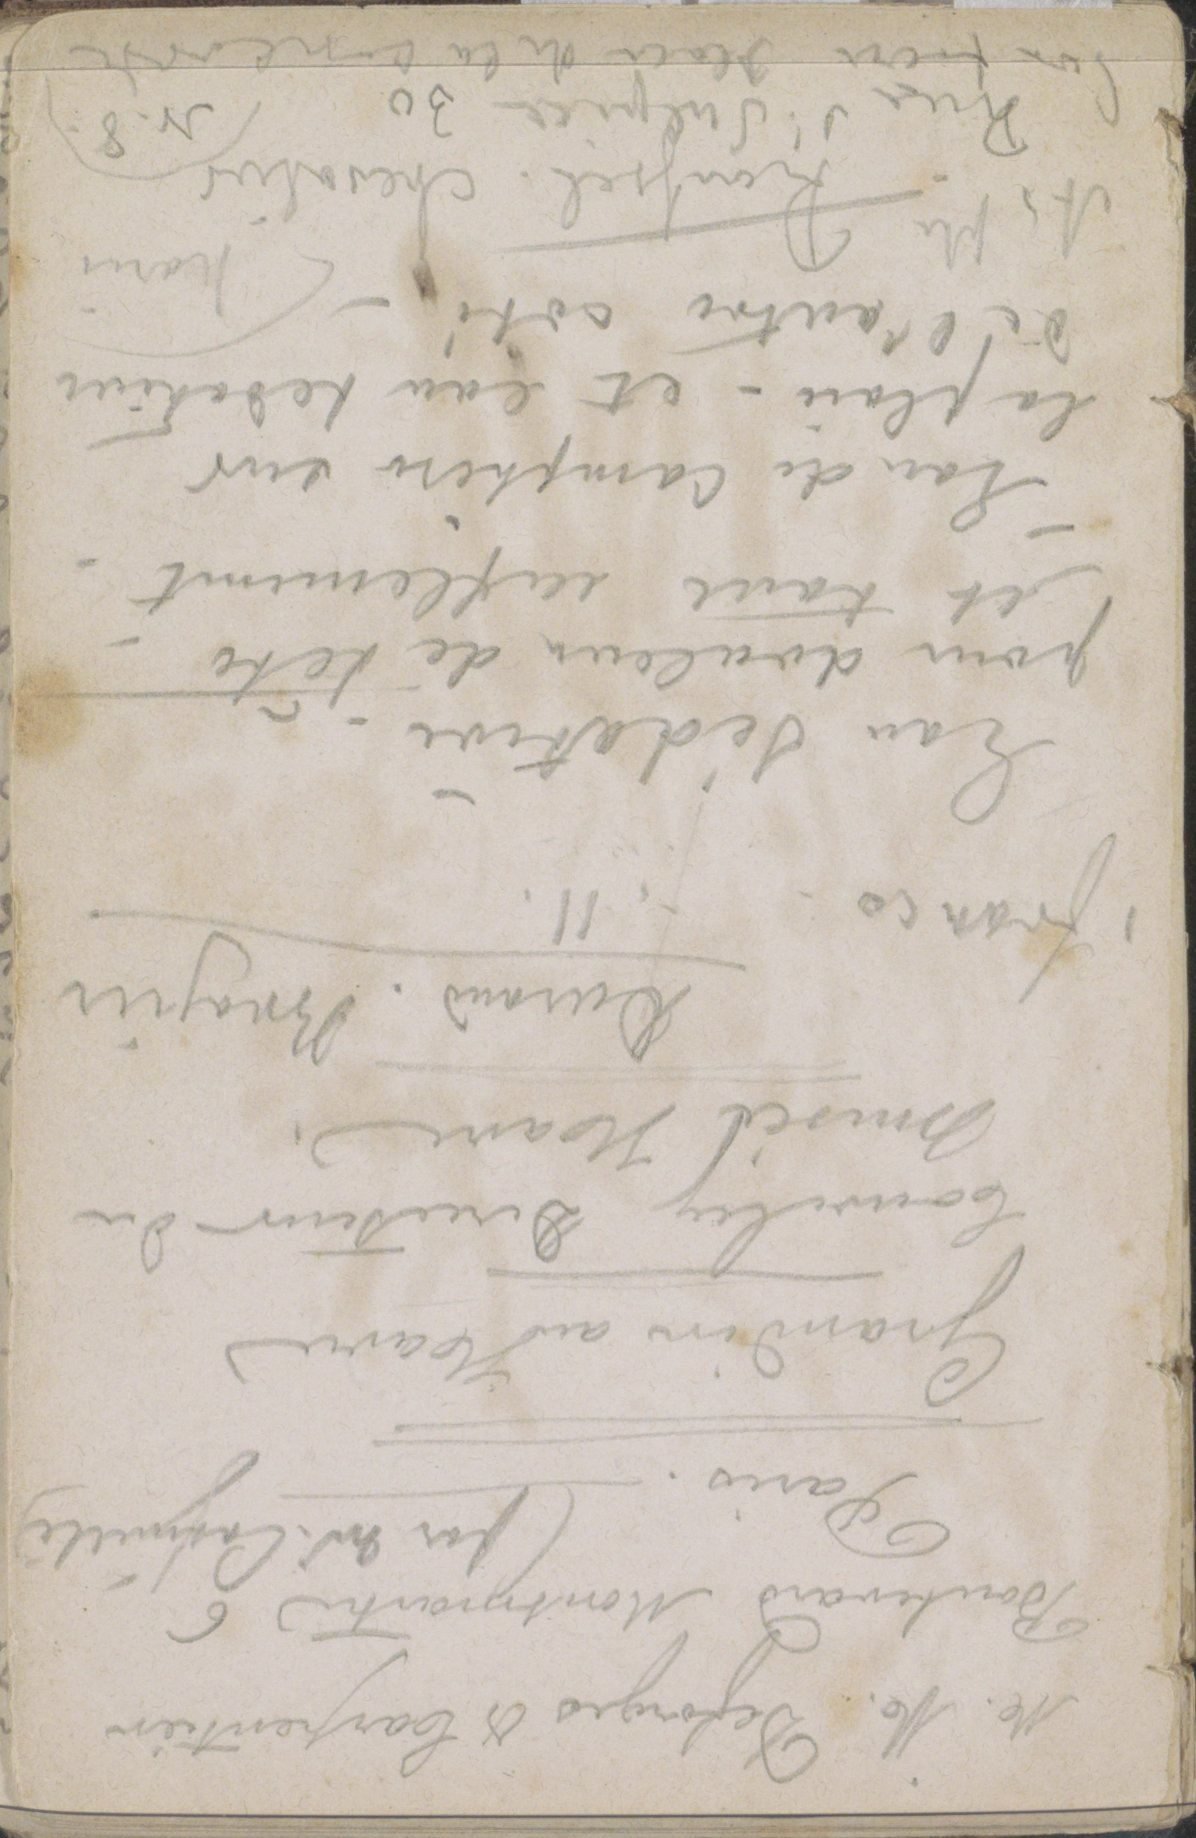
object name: sketchbook leaf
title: Notities, waaronder adressen in Parijs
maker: johannes tavenraat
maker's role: draughtsman, painter, print maker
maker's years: 1809-1881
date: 1862-1864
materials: paper, pencil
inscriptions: annotation: ‘[...]’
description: Blad 65 verso uit een schetsboek met 65 bladen.